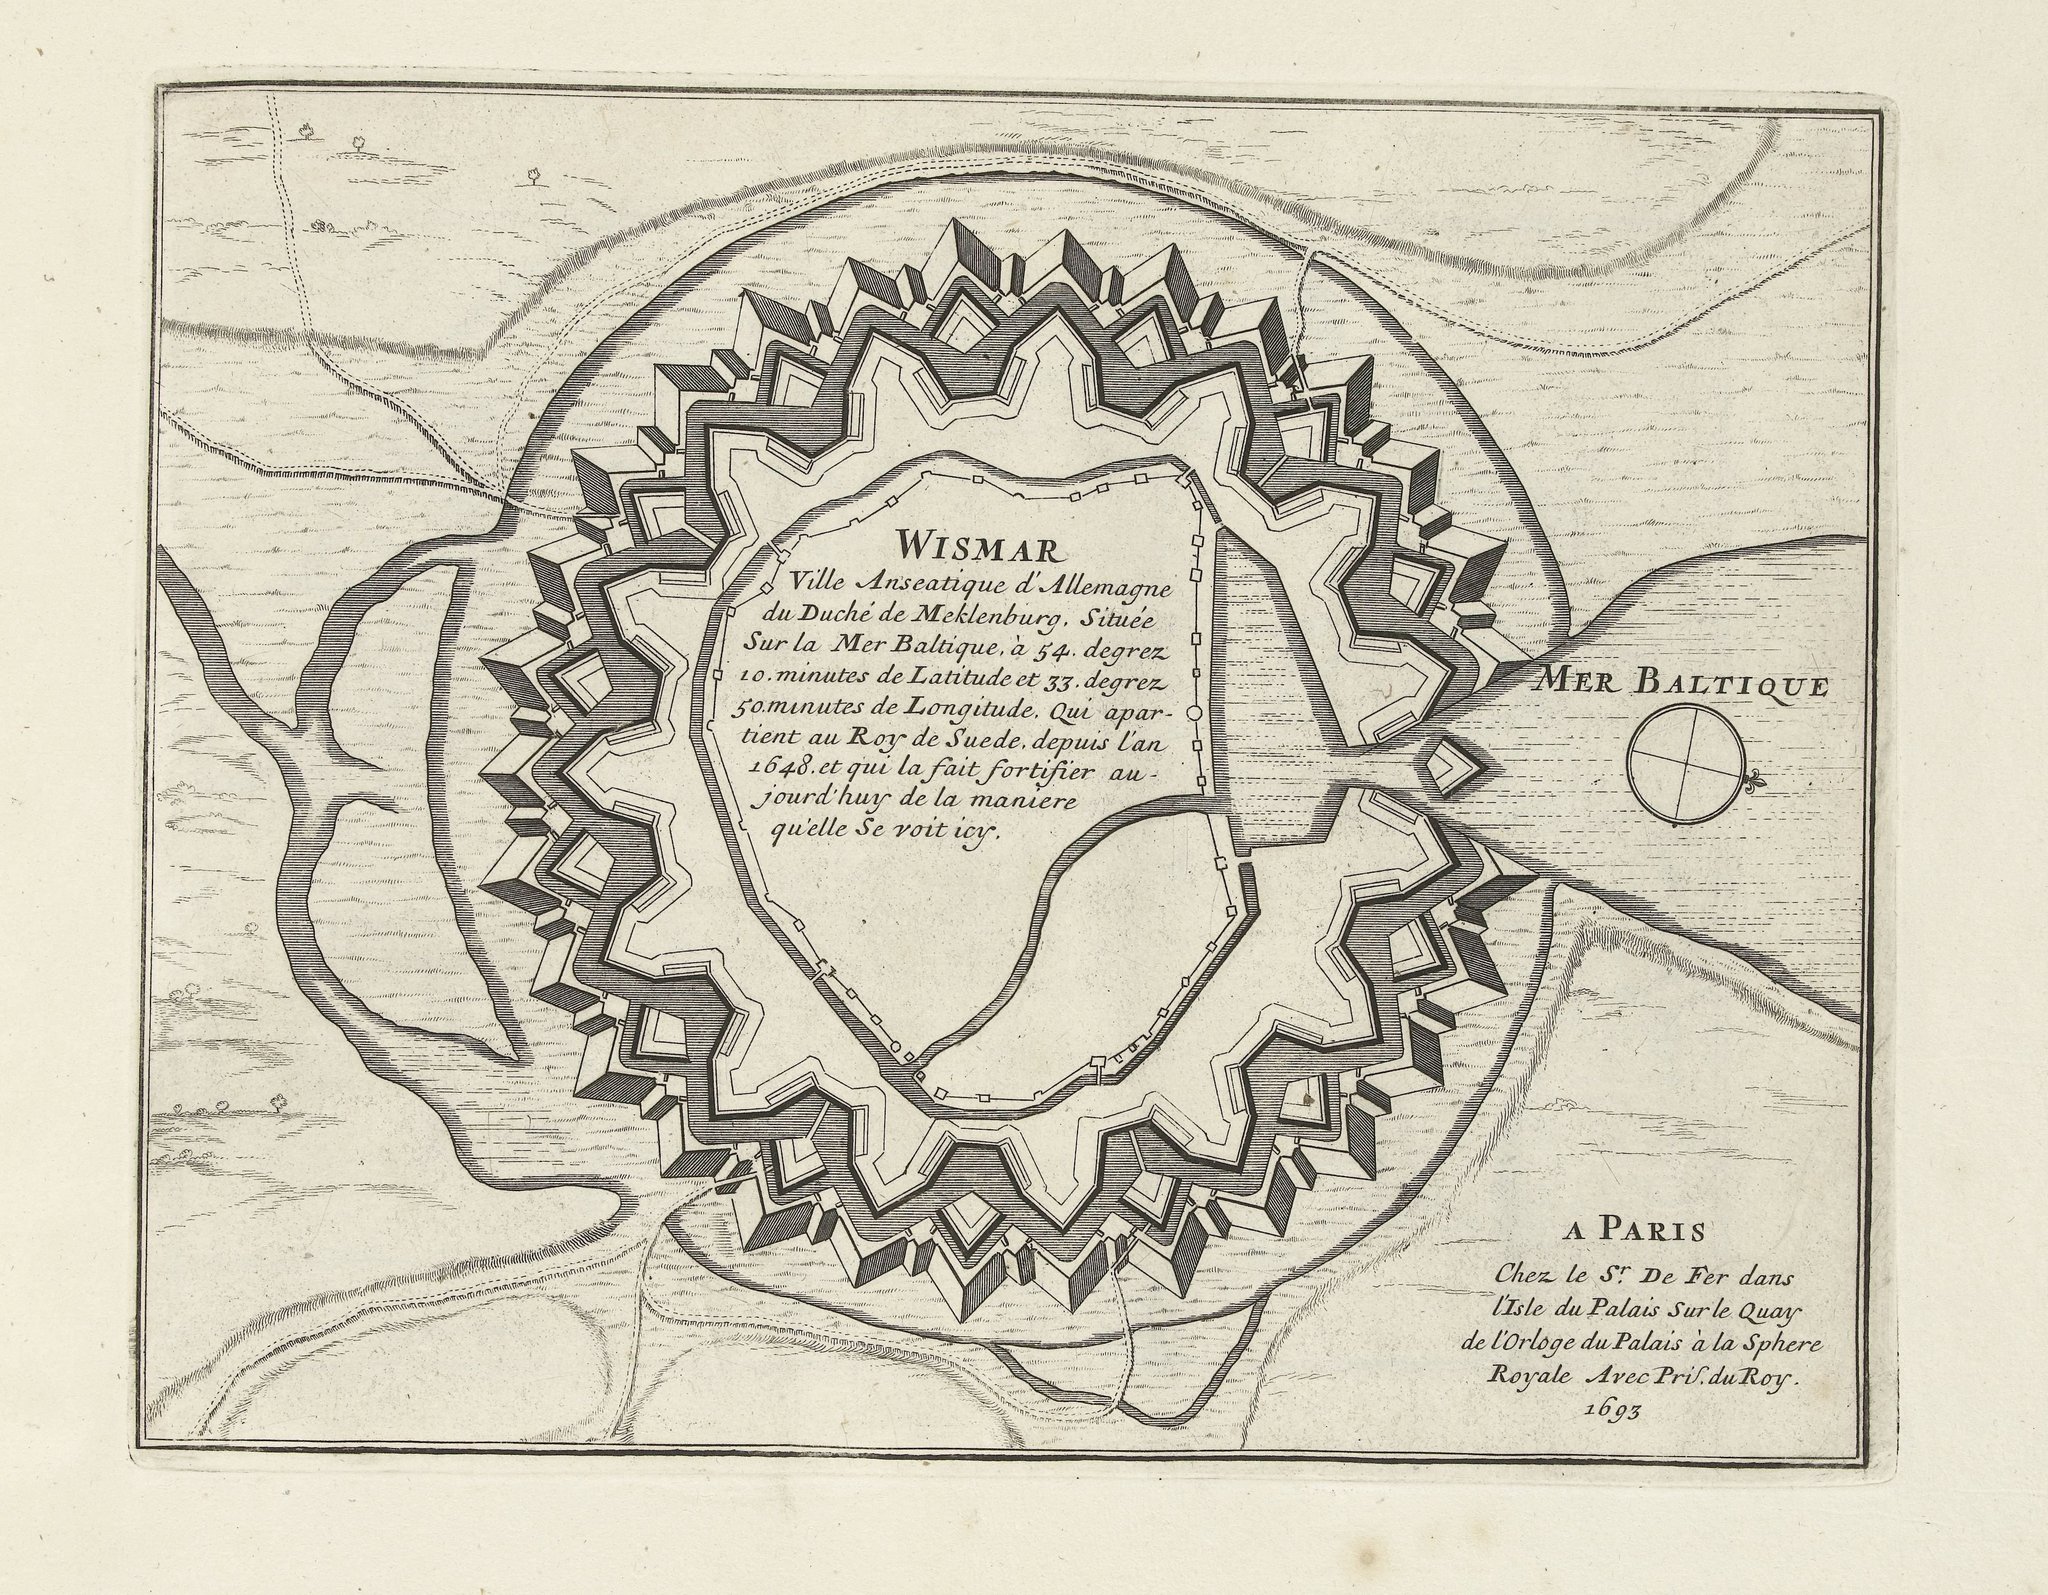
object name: print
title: Plattegrond van Wismar, 1693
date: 1693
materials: paper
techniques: etching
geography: paris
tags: fortress, maps of cities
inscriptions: date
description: Plattegrond van de versterkingen om de Duitse stad Wismar. Onderdeel van het tweede deel (1693) van het prentwerk waarin gebundeld zijn de acht delen van Les forces de l'Europe uitgegeven tussen 1693-1697. Het prentwerk bestaat uit 175 platen met plannen (afkomstig van Sébastien Le Prestre, Seigneur de Vauban) van vermaarde sterke steden en vestingen in de Negenjarige Oorlog. Titel en opschriften in het Frans.